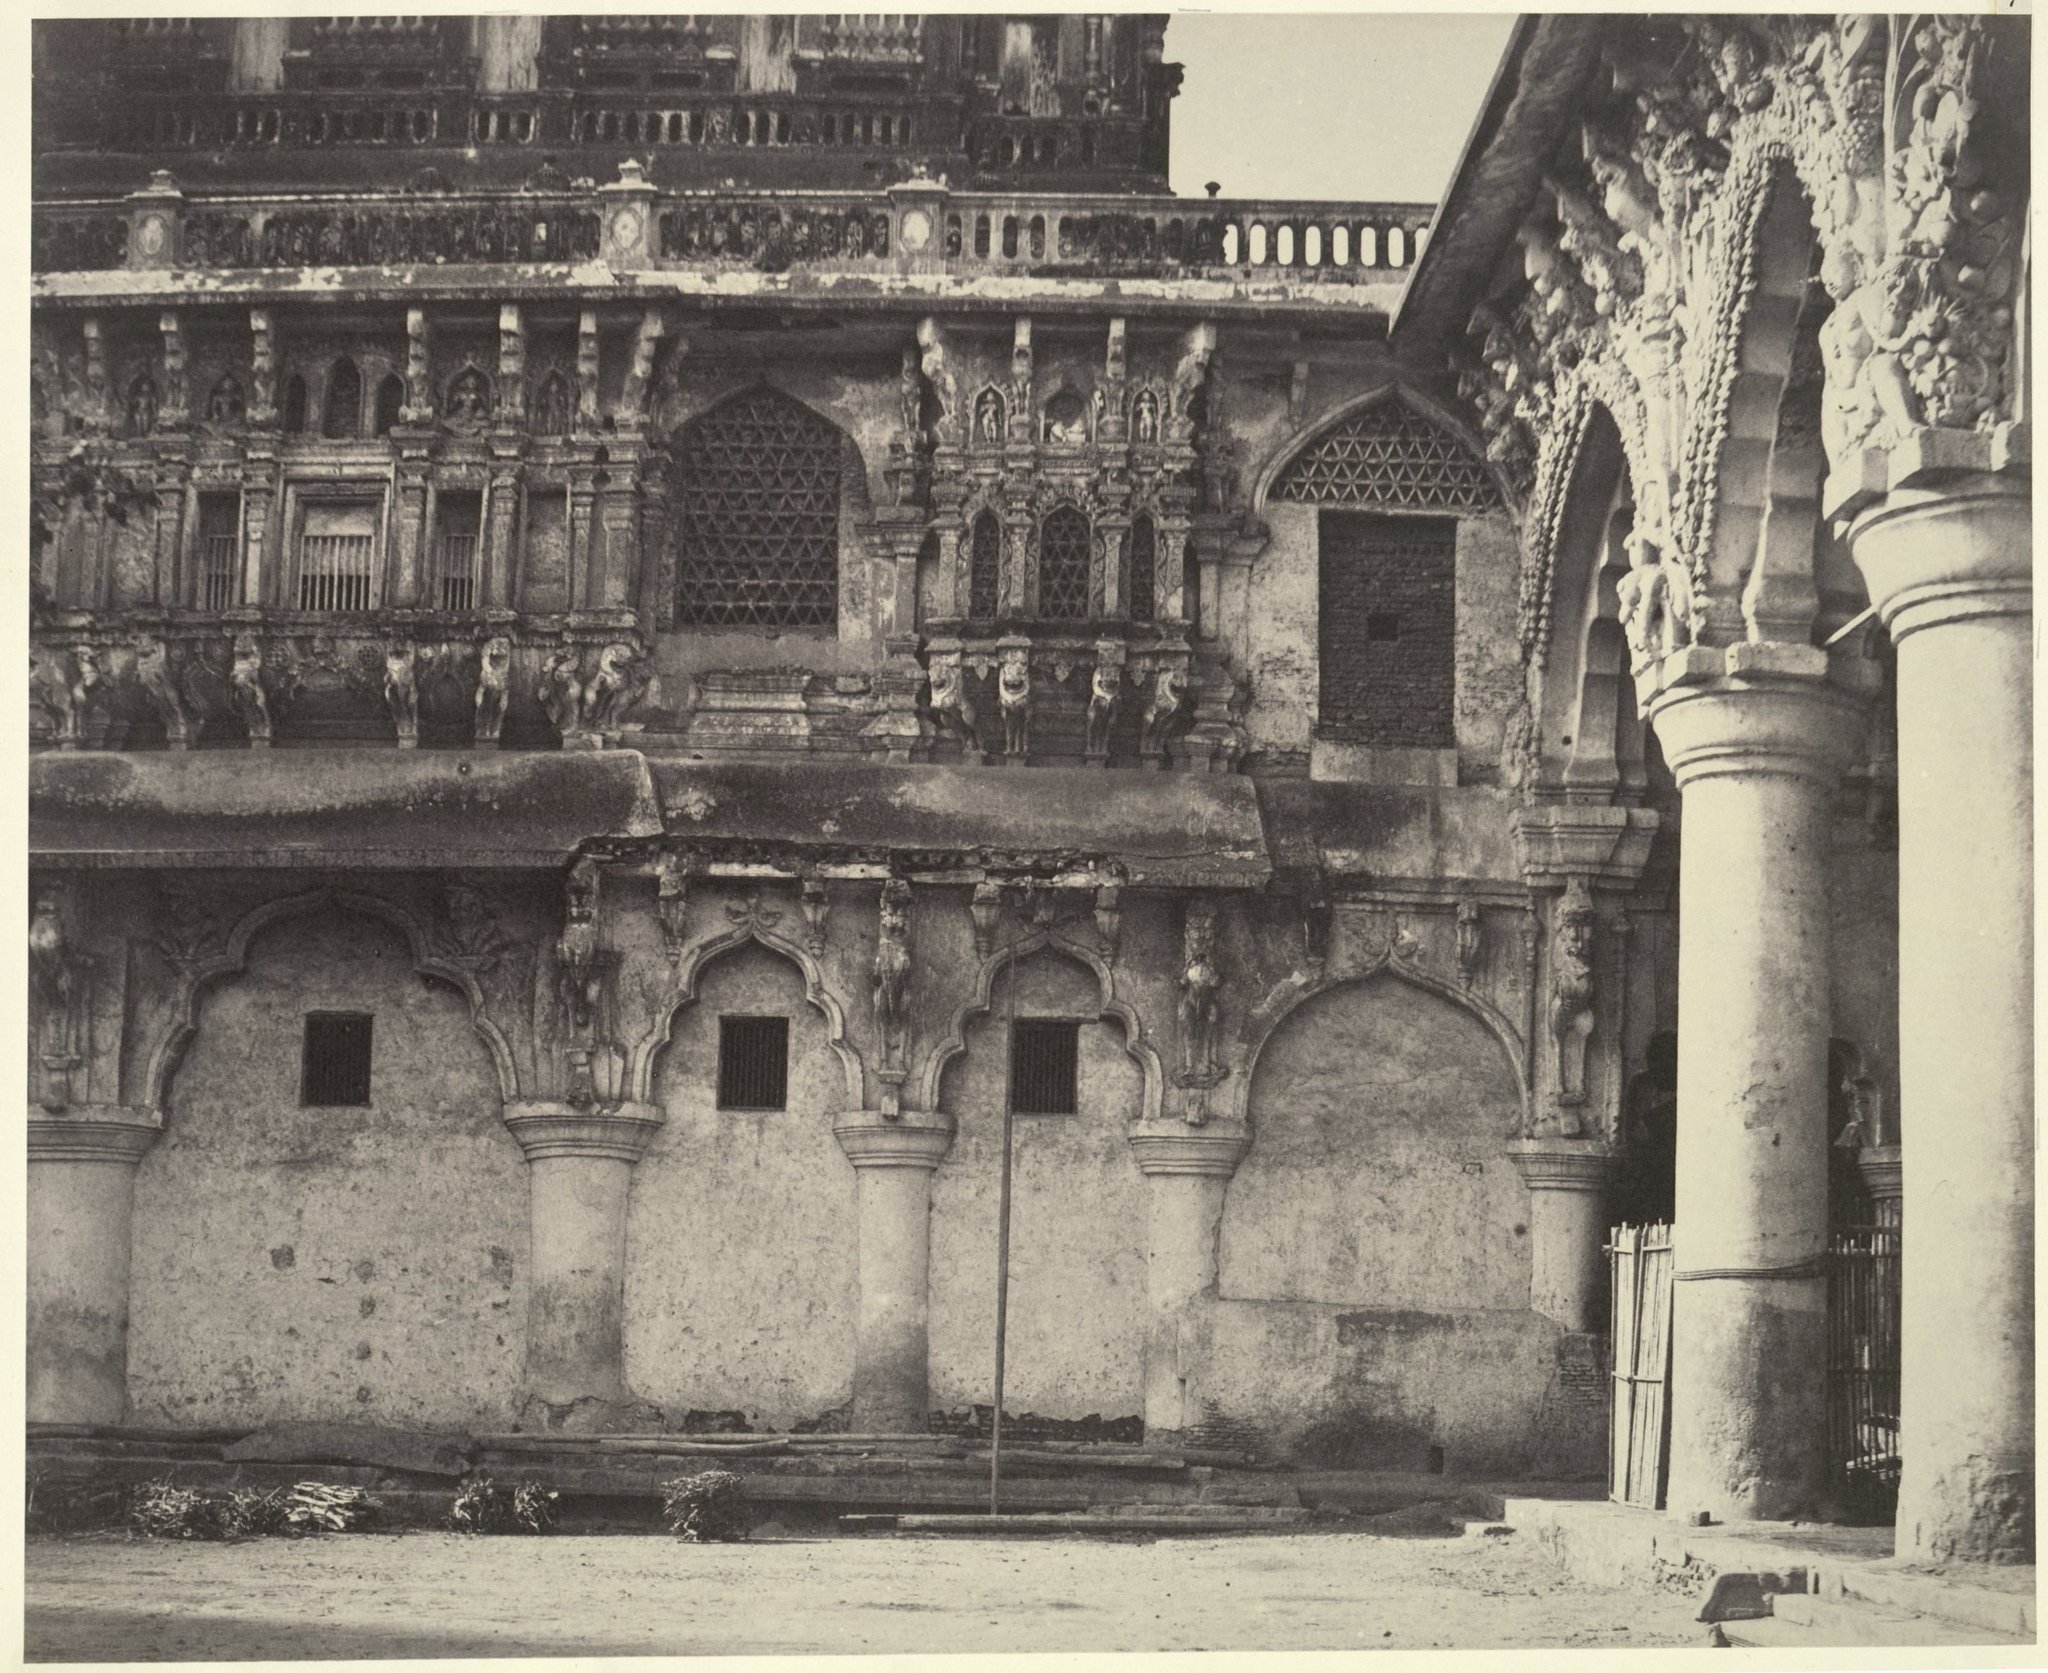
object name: photograph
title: Courtyard of the royal palace at Thanjavur, Tamil Nadu, India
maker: linnaeus tripe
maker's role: fotograaf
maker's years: 1822-1902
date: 1858-1860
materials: cardboard, photographic support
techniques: salted paper print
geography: thanjavur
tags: thanjavur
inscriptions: number: ‘7.’, monogram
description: Binnenplaats van het Radjapaleis te Tanjore in India. Plaat 7 uit het album Photographic Views in Tanjore and Trivady